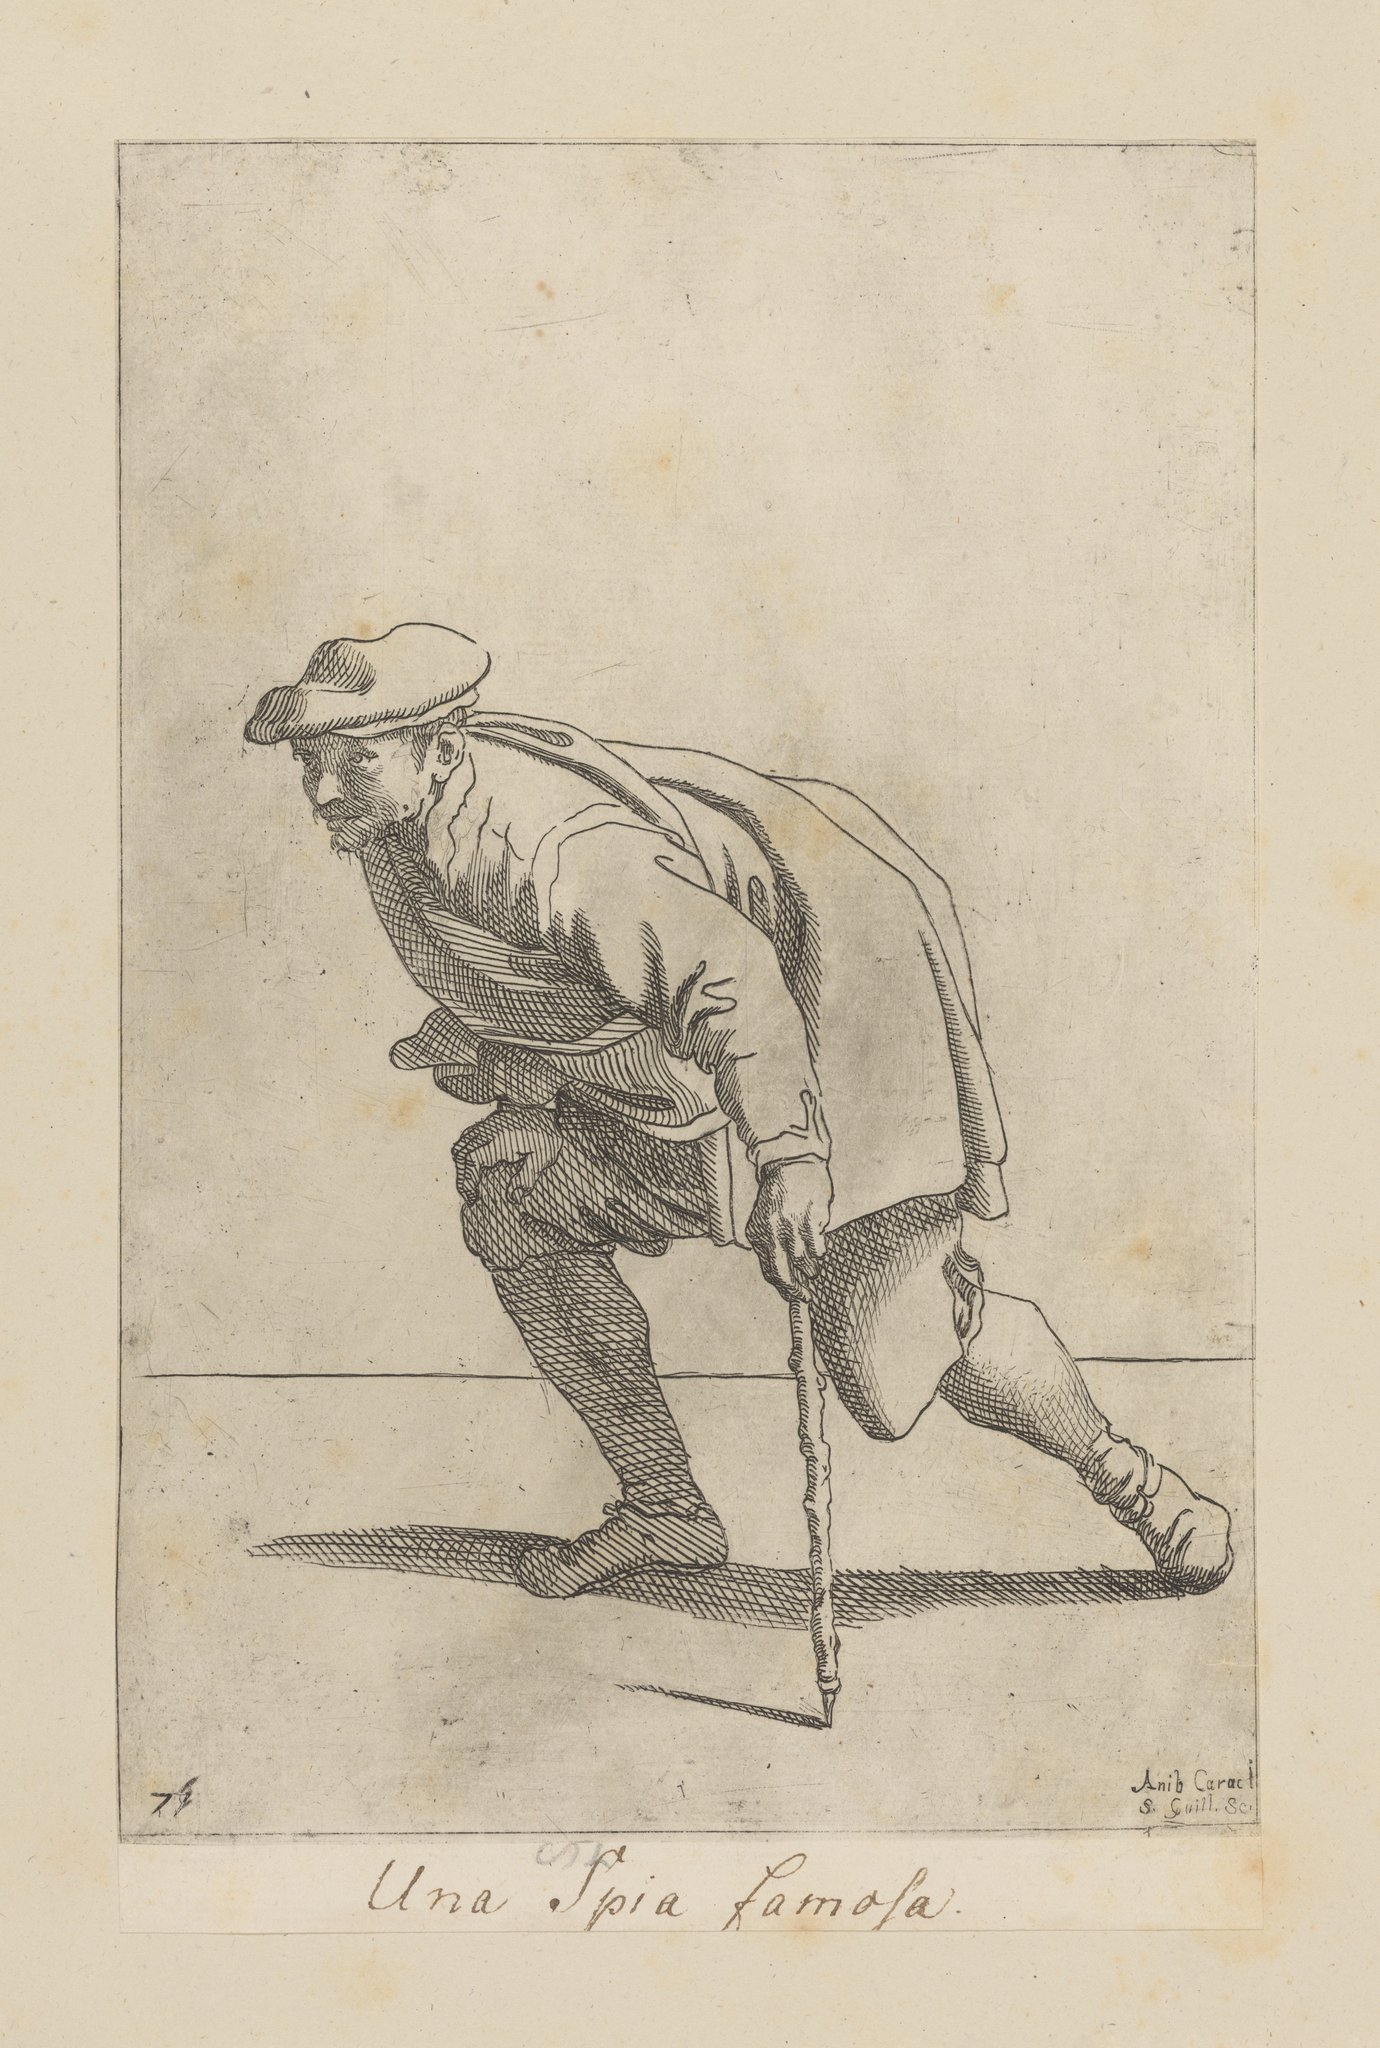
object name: print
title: Plate 77: A well known spy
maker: simon guillain ii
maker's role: artist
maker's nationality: french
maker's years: 1618-1718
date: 1646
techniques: etching